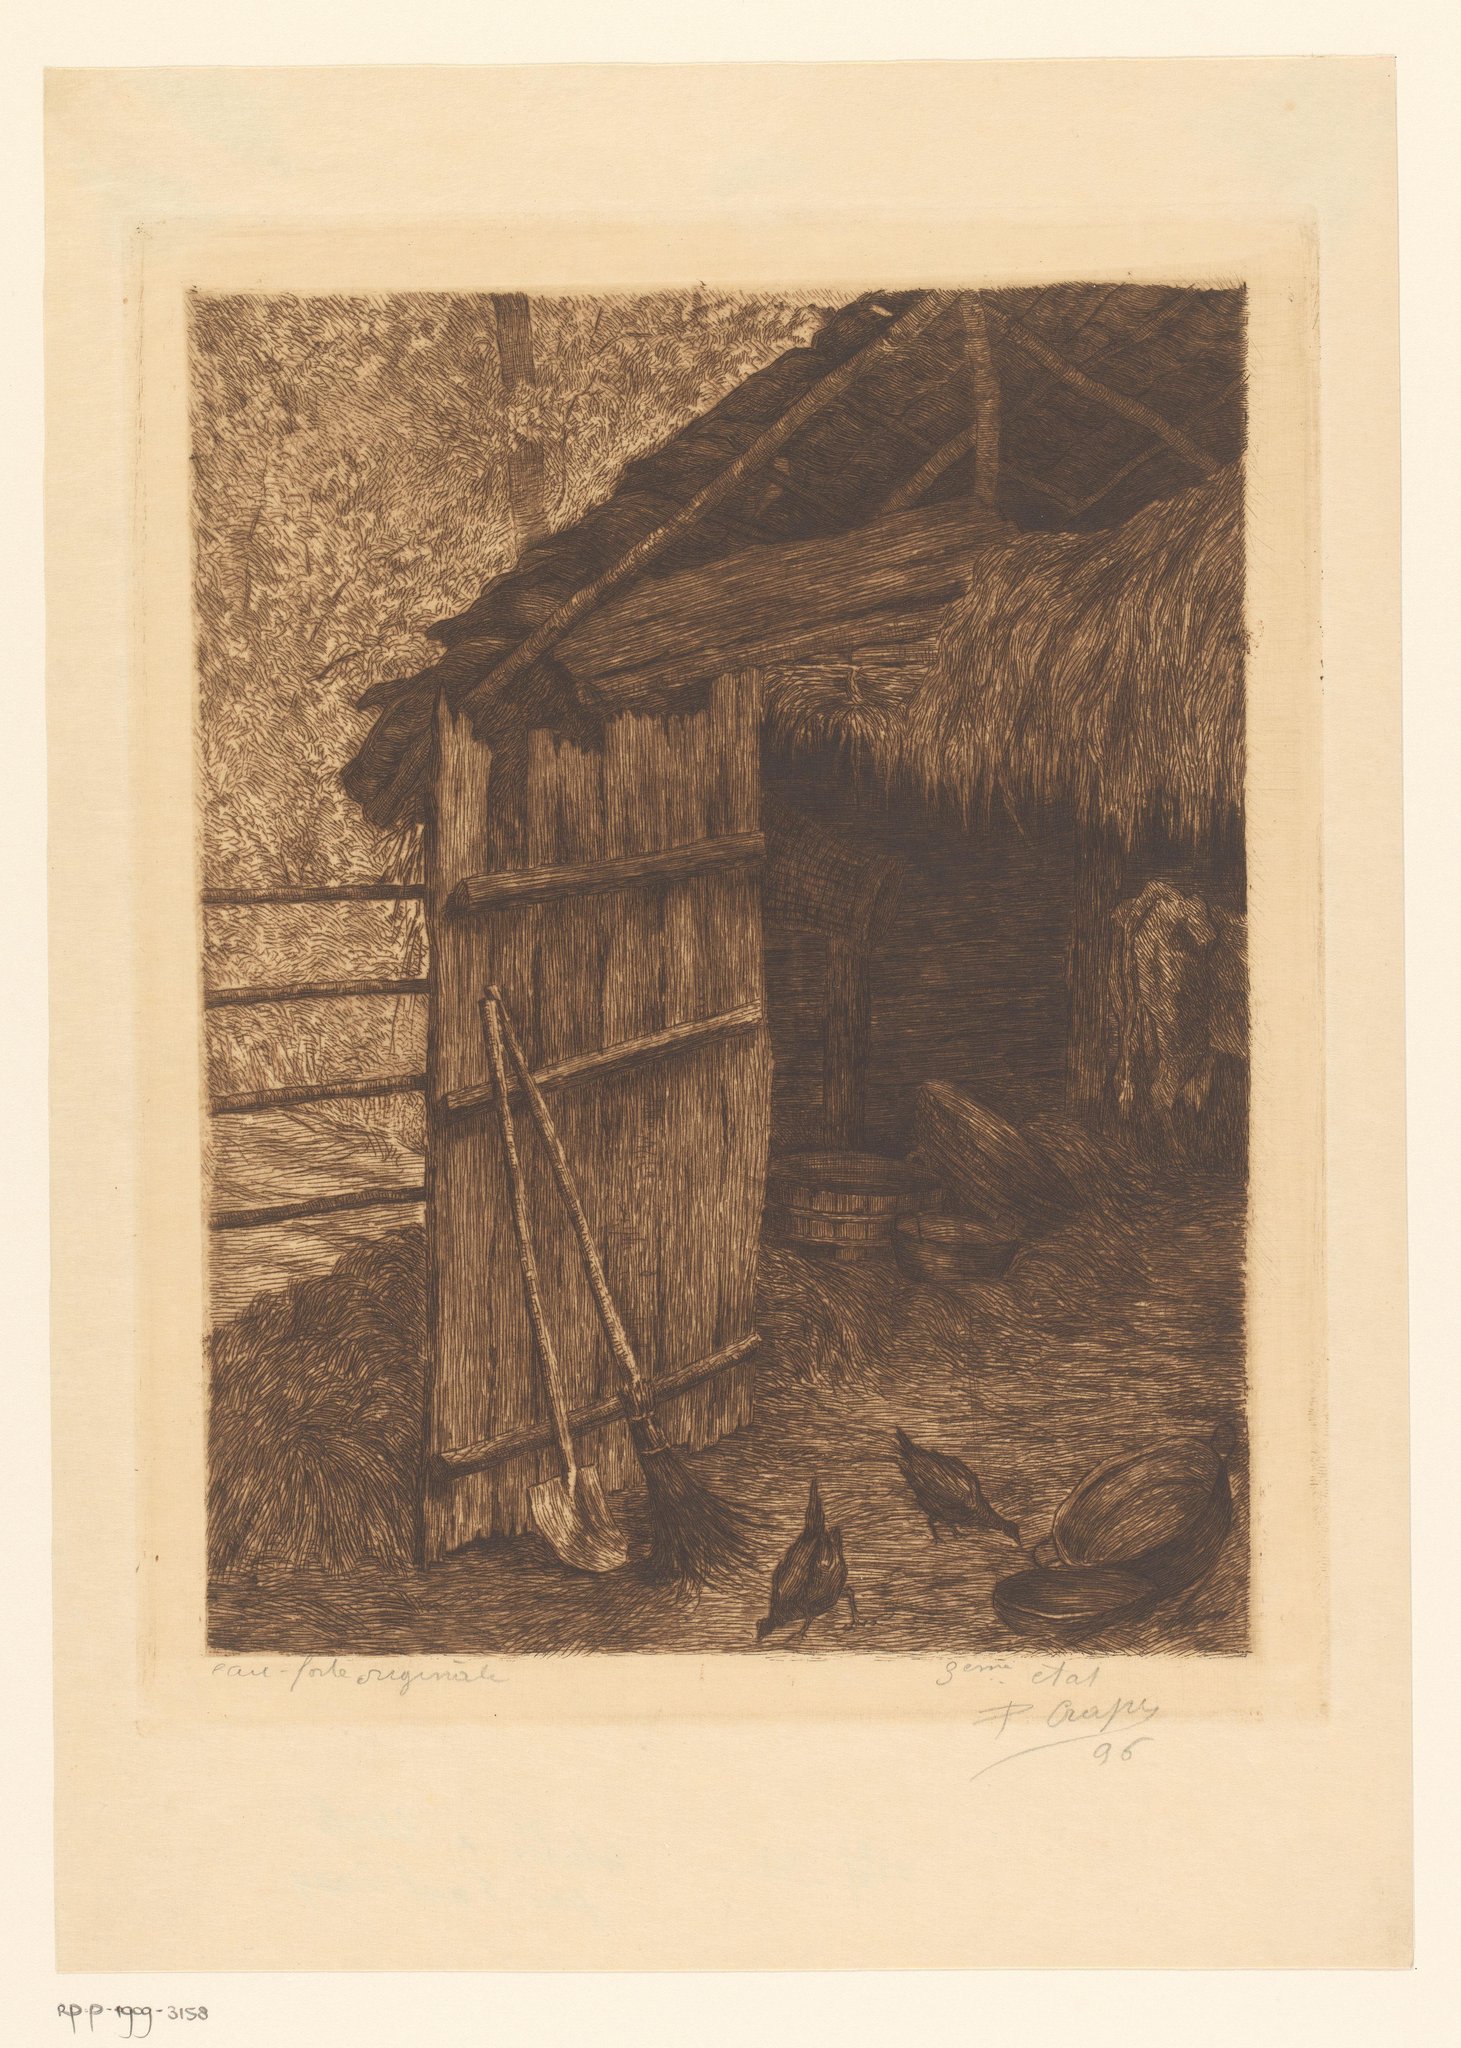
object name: print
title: Koe en twee kippen in een schuur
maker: pol craps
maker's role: print maker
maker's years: 1877-1939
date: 1896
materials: paper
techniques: drypoint, etching, intaglio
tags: barn, cow, fowl (cock, hen, chicken, etc.)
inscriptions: annotation: ‘eau-forte originale; 3eme etat’